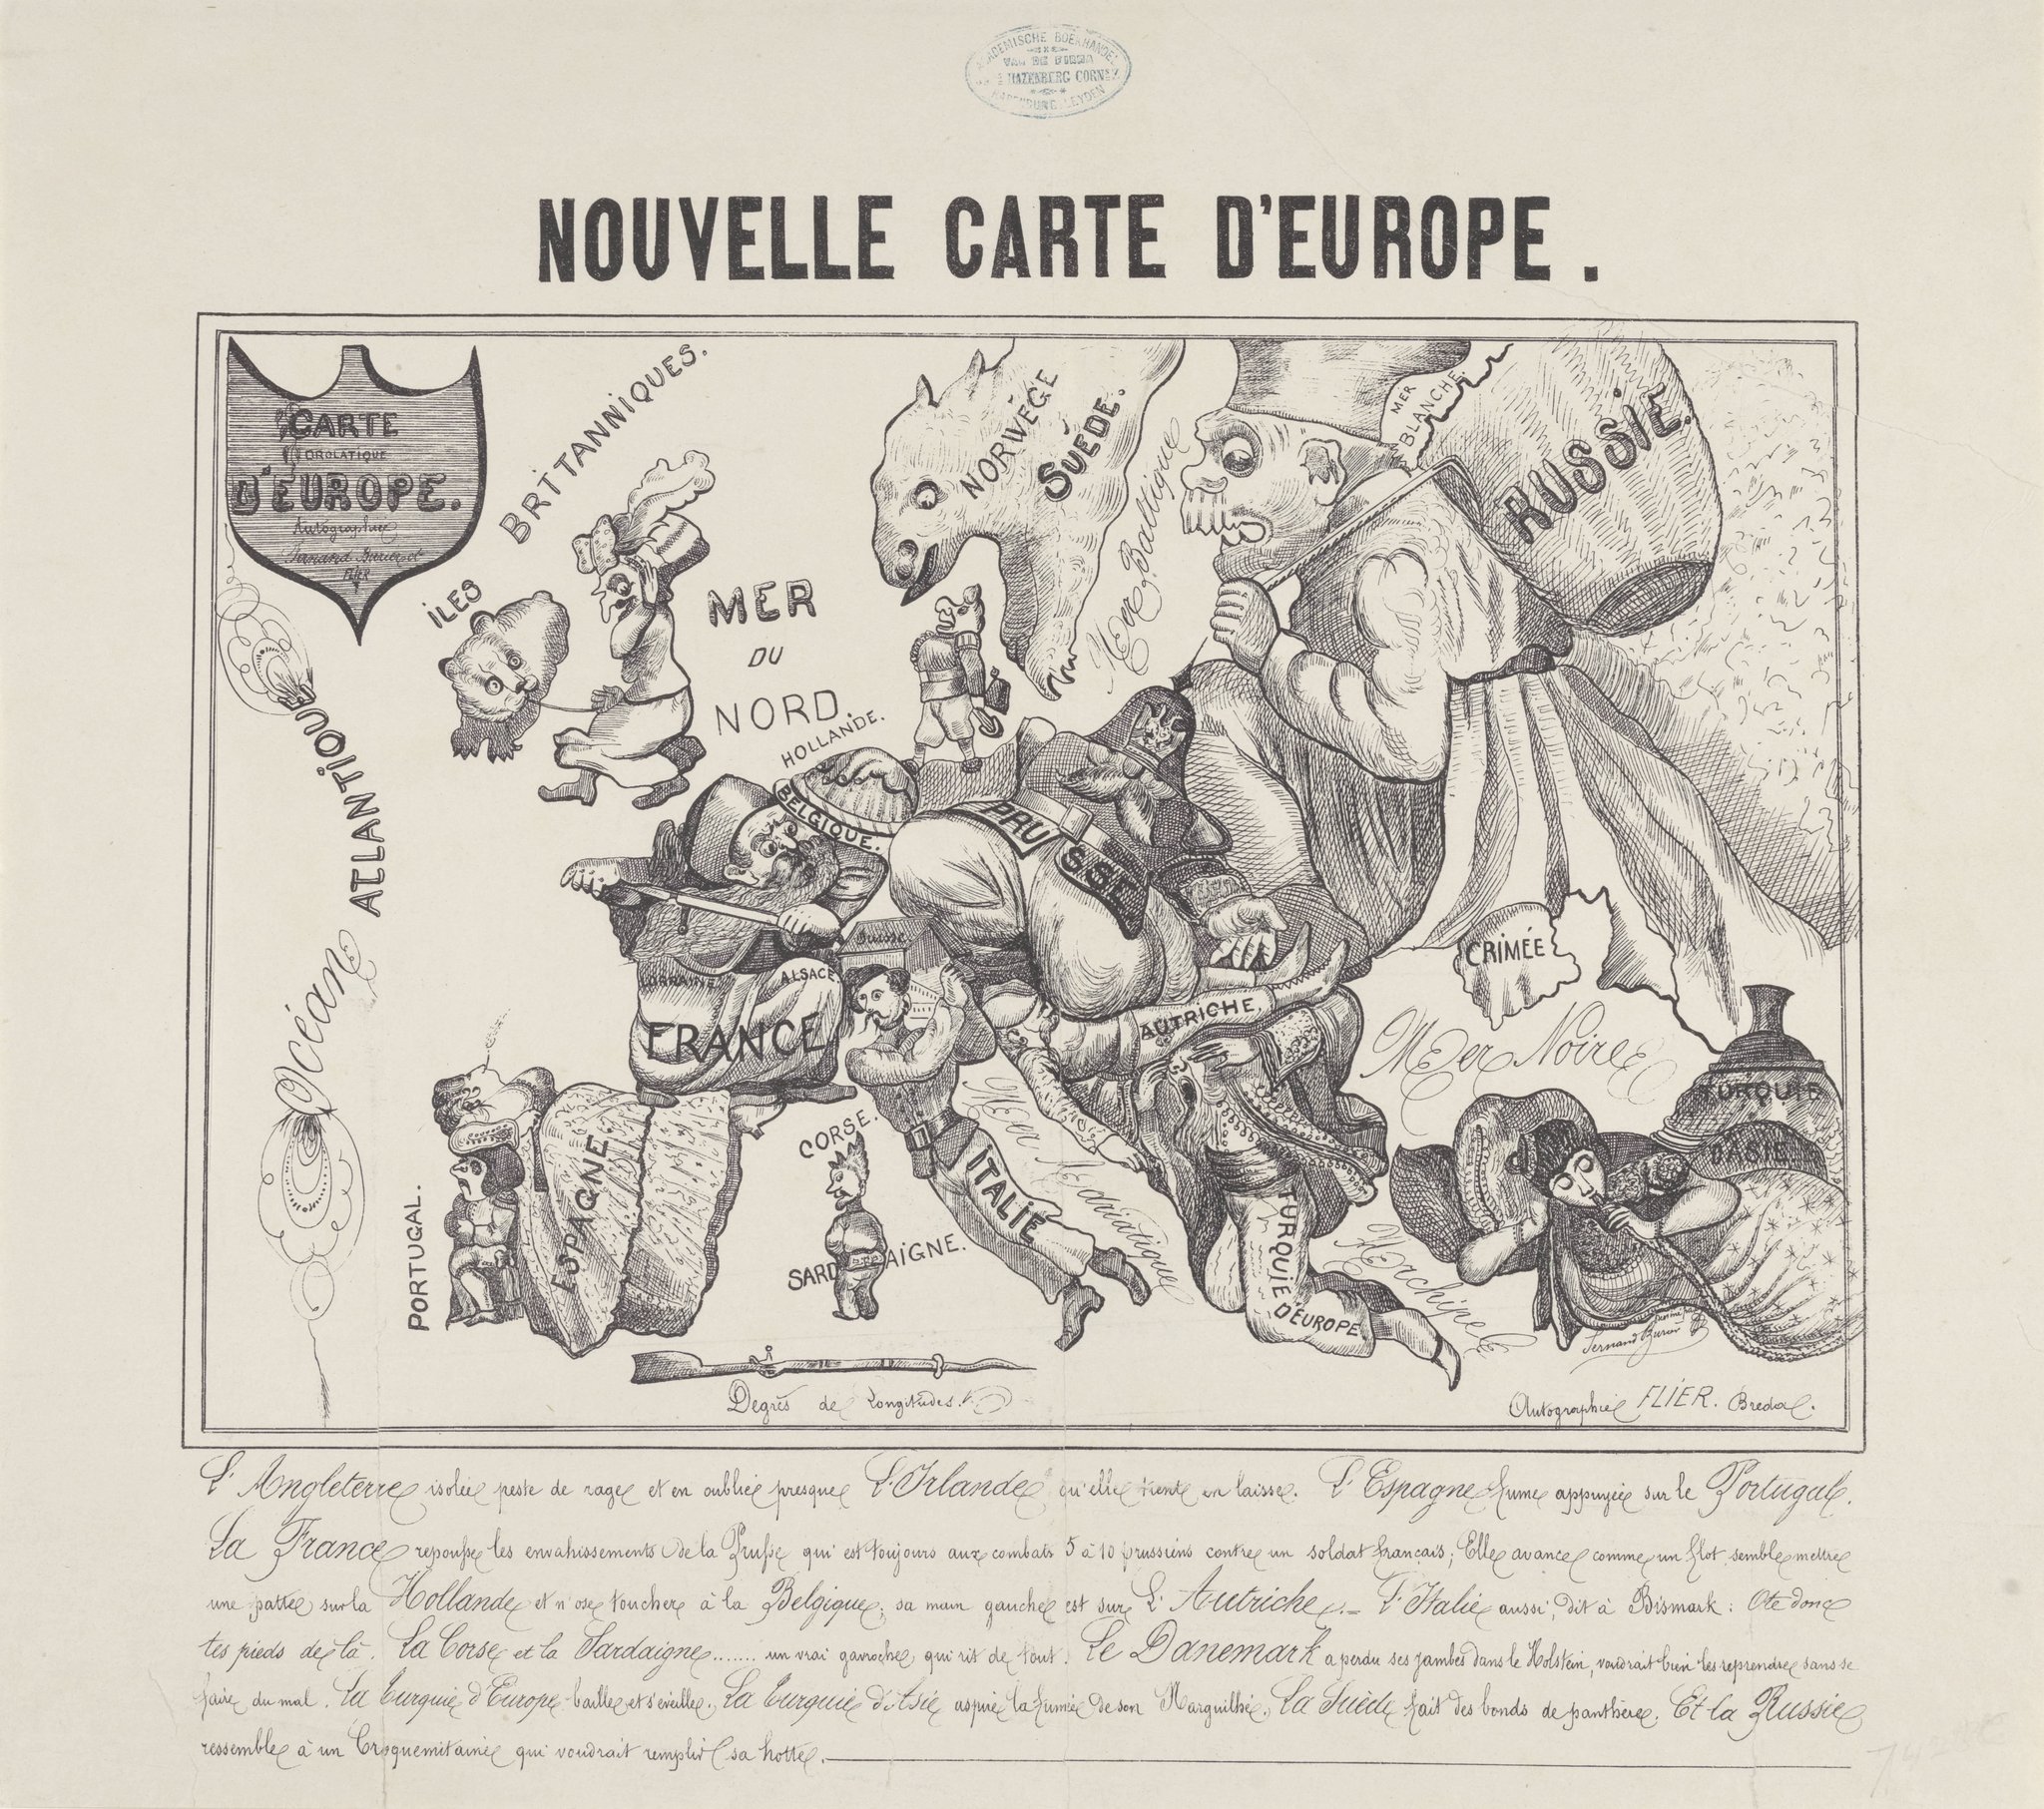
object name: print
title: Kaart van Europa waarin alle landen door personen zijn voorgesteld, ca. 1867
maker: flier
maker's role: print maker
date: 1867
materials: paper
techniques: lithograph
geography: breda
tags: (map of) europe, europe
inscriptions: company name: ‘Academische Boekhandel van de firma ... Hazenberg Corn.sZ / Rapenburg Leyden’, collector's mark: Lugt 2228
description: Politieke kaart van Europa waarop alle landen door personen zijn voorgesteld, ca. 1867. Met Otto van Bismarck centraal in Pruisen. Met zesregelig onderschrift in het Frans.